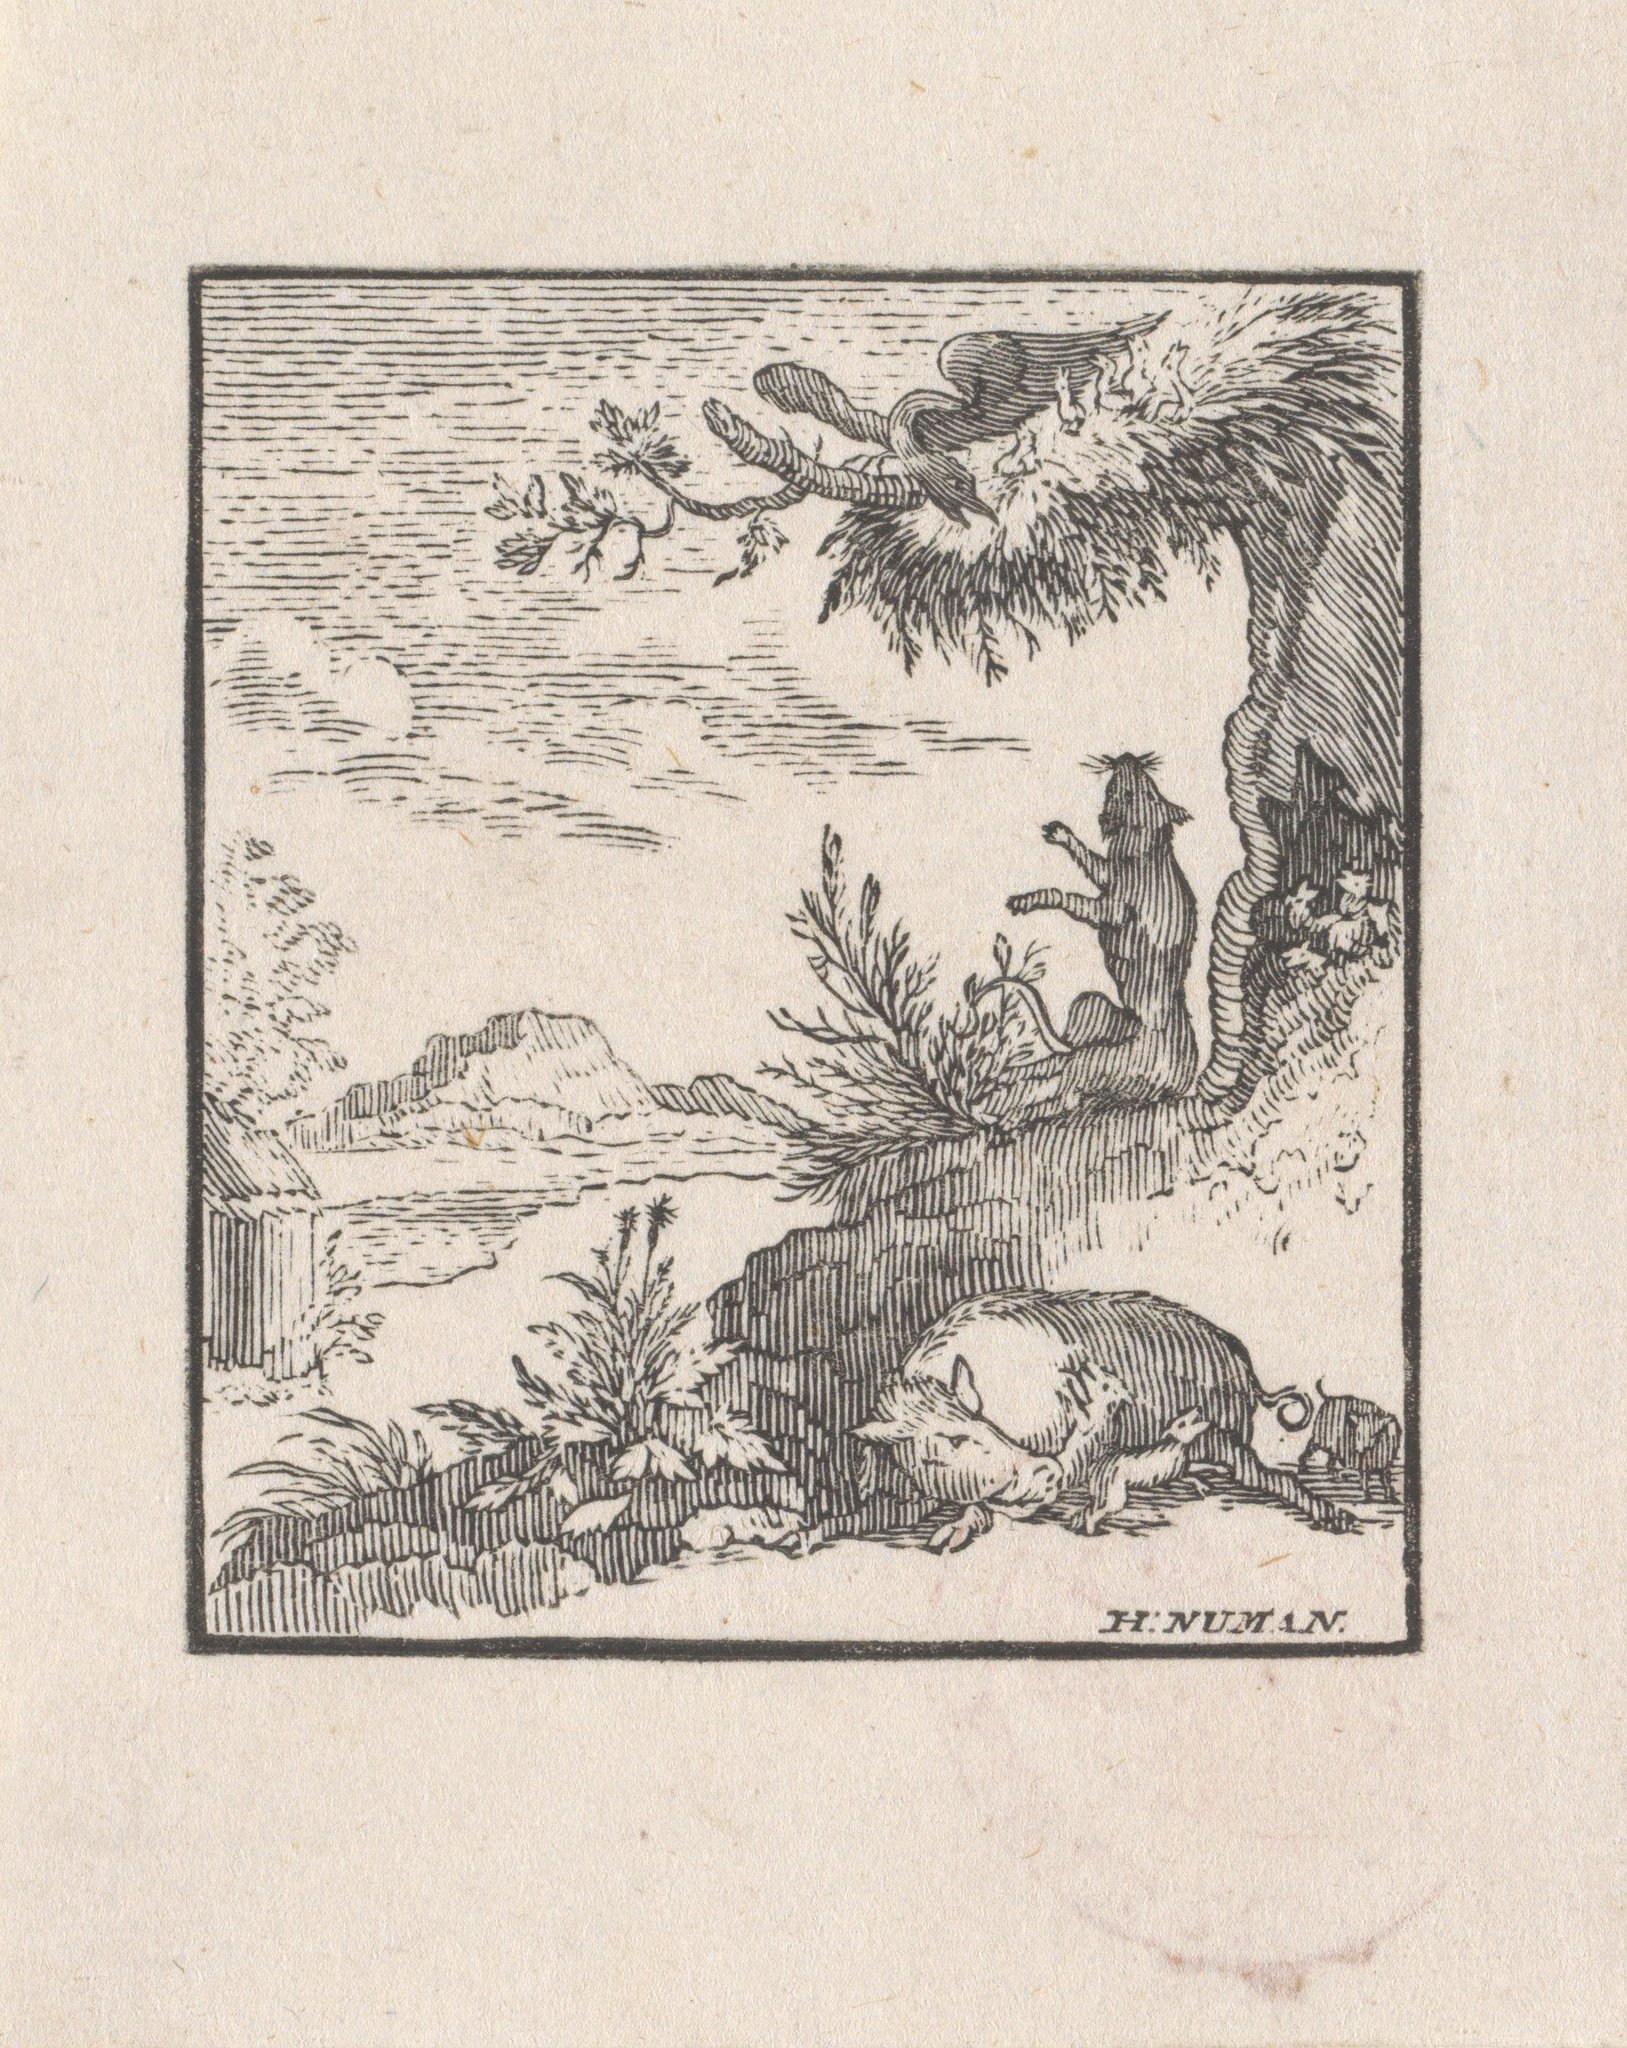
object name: print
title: Voorstelling van een verhaal uit de Aesopus fabelen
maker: hendrik numan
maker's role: draughtsman, print maker, publisher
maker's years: 1736-1788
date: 1746-1788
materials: paper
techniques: woodcut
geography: haarlem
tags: fables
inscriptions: collector's mark: Lugt 240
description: Een vos kijkt omhoog naar een grote vogel op een boomtak. Op de voorgrond ligt een zwijn met jongen.